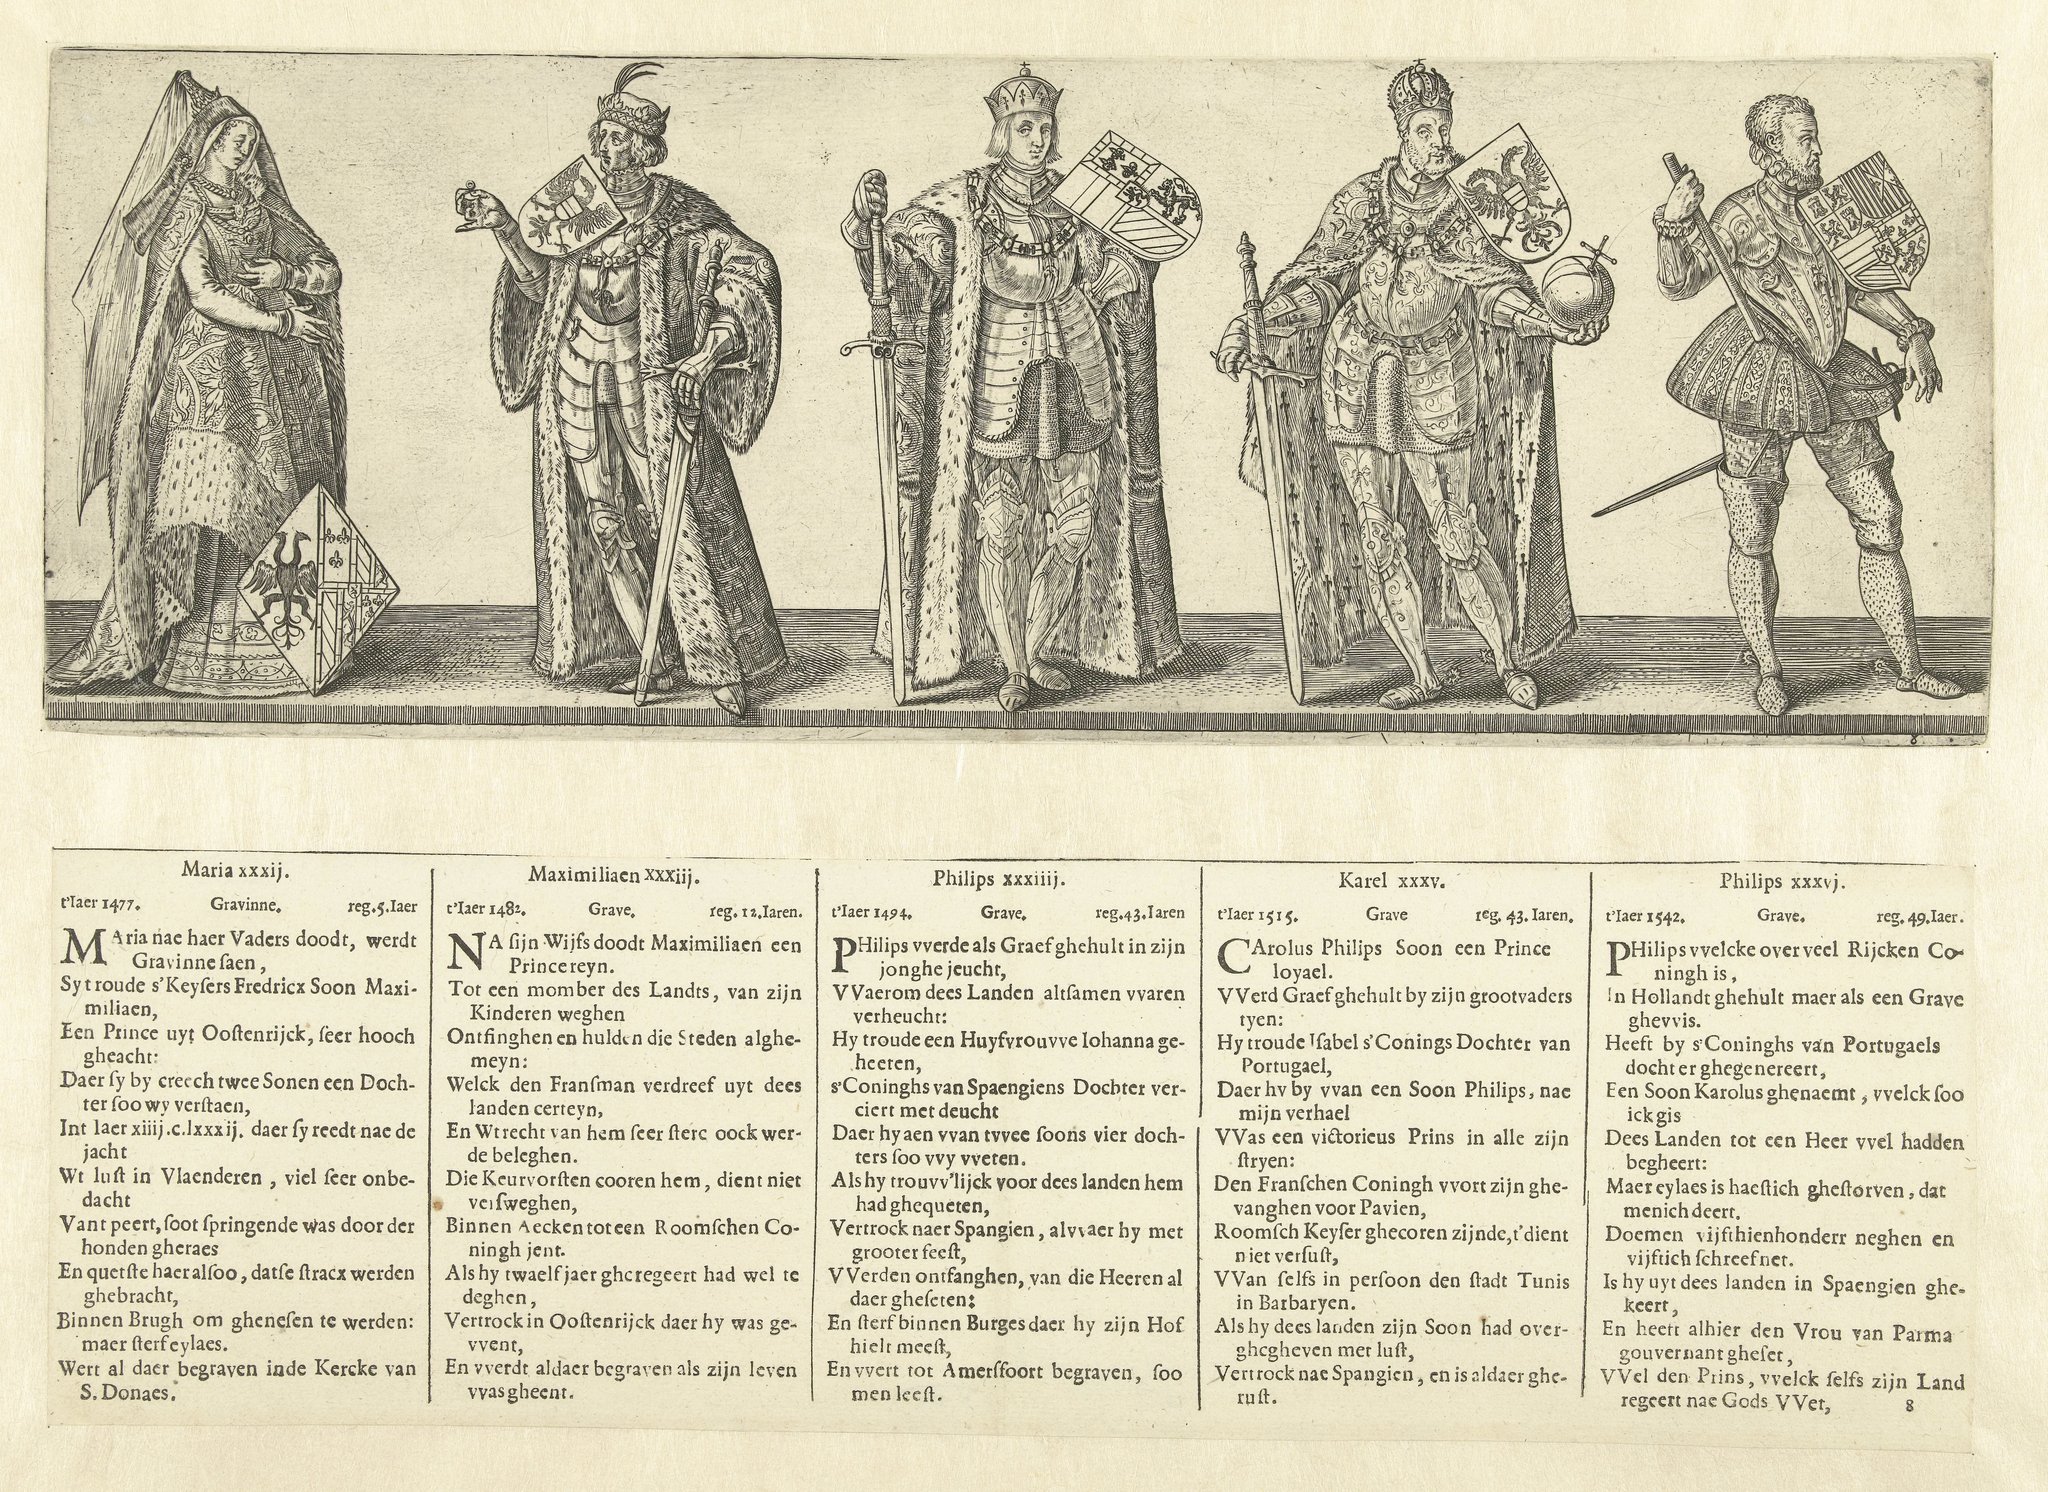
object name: print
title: Graven en gravinnen van Holland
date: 1584-1585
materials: paper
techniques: engraving, letterpress printing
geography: haarlem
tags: philip ii of spain, brussels, bruges, maria (hertogin van bourgondië), maximilian i (holy roman emperor), filips de schone (hertog van bourgondië), ghent, charles v (holy roman emperor and king of spain)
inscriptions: collector's mark: Lugt 2228a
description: Voorstelling van één vrouw met schild en staf, en vier mannen met zwaard en schild. Het gaat volgens het bijbehorende onderschrift om gravin van Holland Maria XXXII en graven van Holland Maximiliaan XXXIII, Filips XXXIV, Karel XXXV en Filips XXXVI (bedoeld zijn Maria van Bourgondië, Maximiliaan I van Habsburg, Filips de Schone, Karel V van Habsburg en Filips II). Deze prent is onderdeel van een serie van acht genummerde prenten van de graven en gravinnen van Holland met bijbehorende verklarende Nederlandse teksten in boekdruk. Prent en tekst zijn steeds op één blad bevestigd. Overigens lijkt er van de jaartallen die in de onderschriften vermeld staan weinig te kloppen.